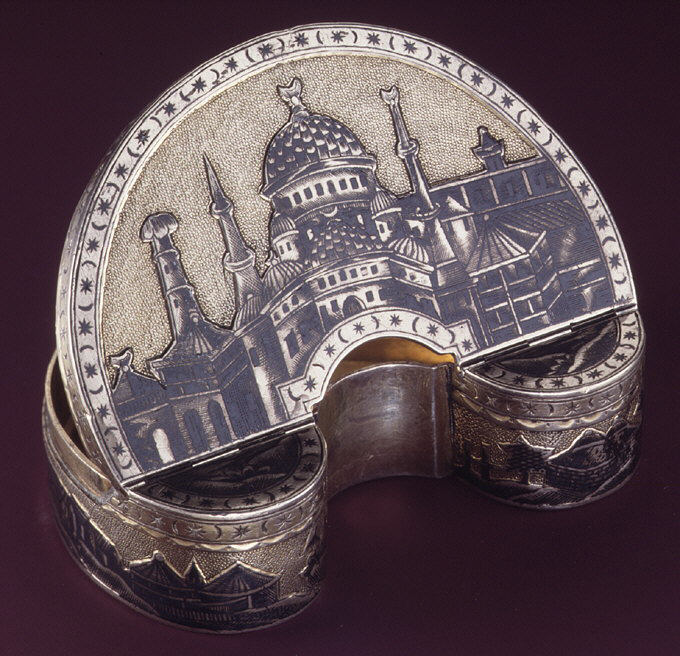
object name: box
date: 1780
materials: gilt, niello, silver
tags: buildings